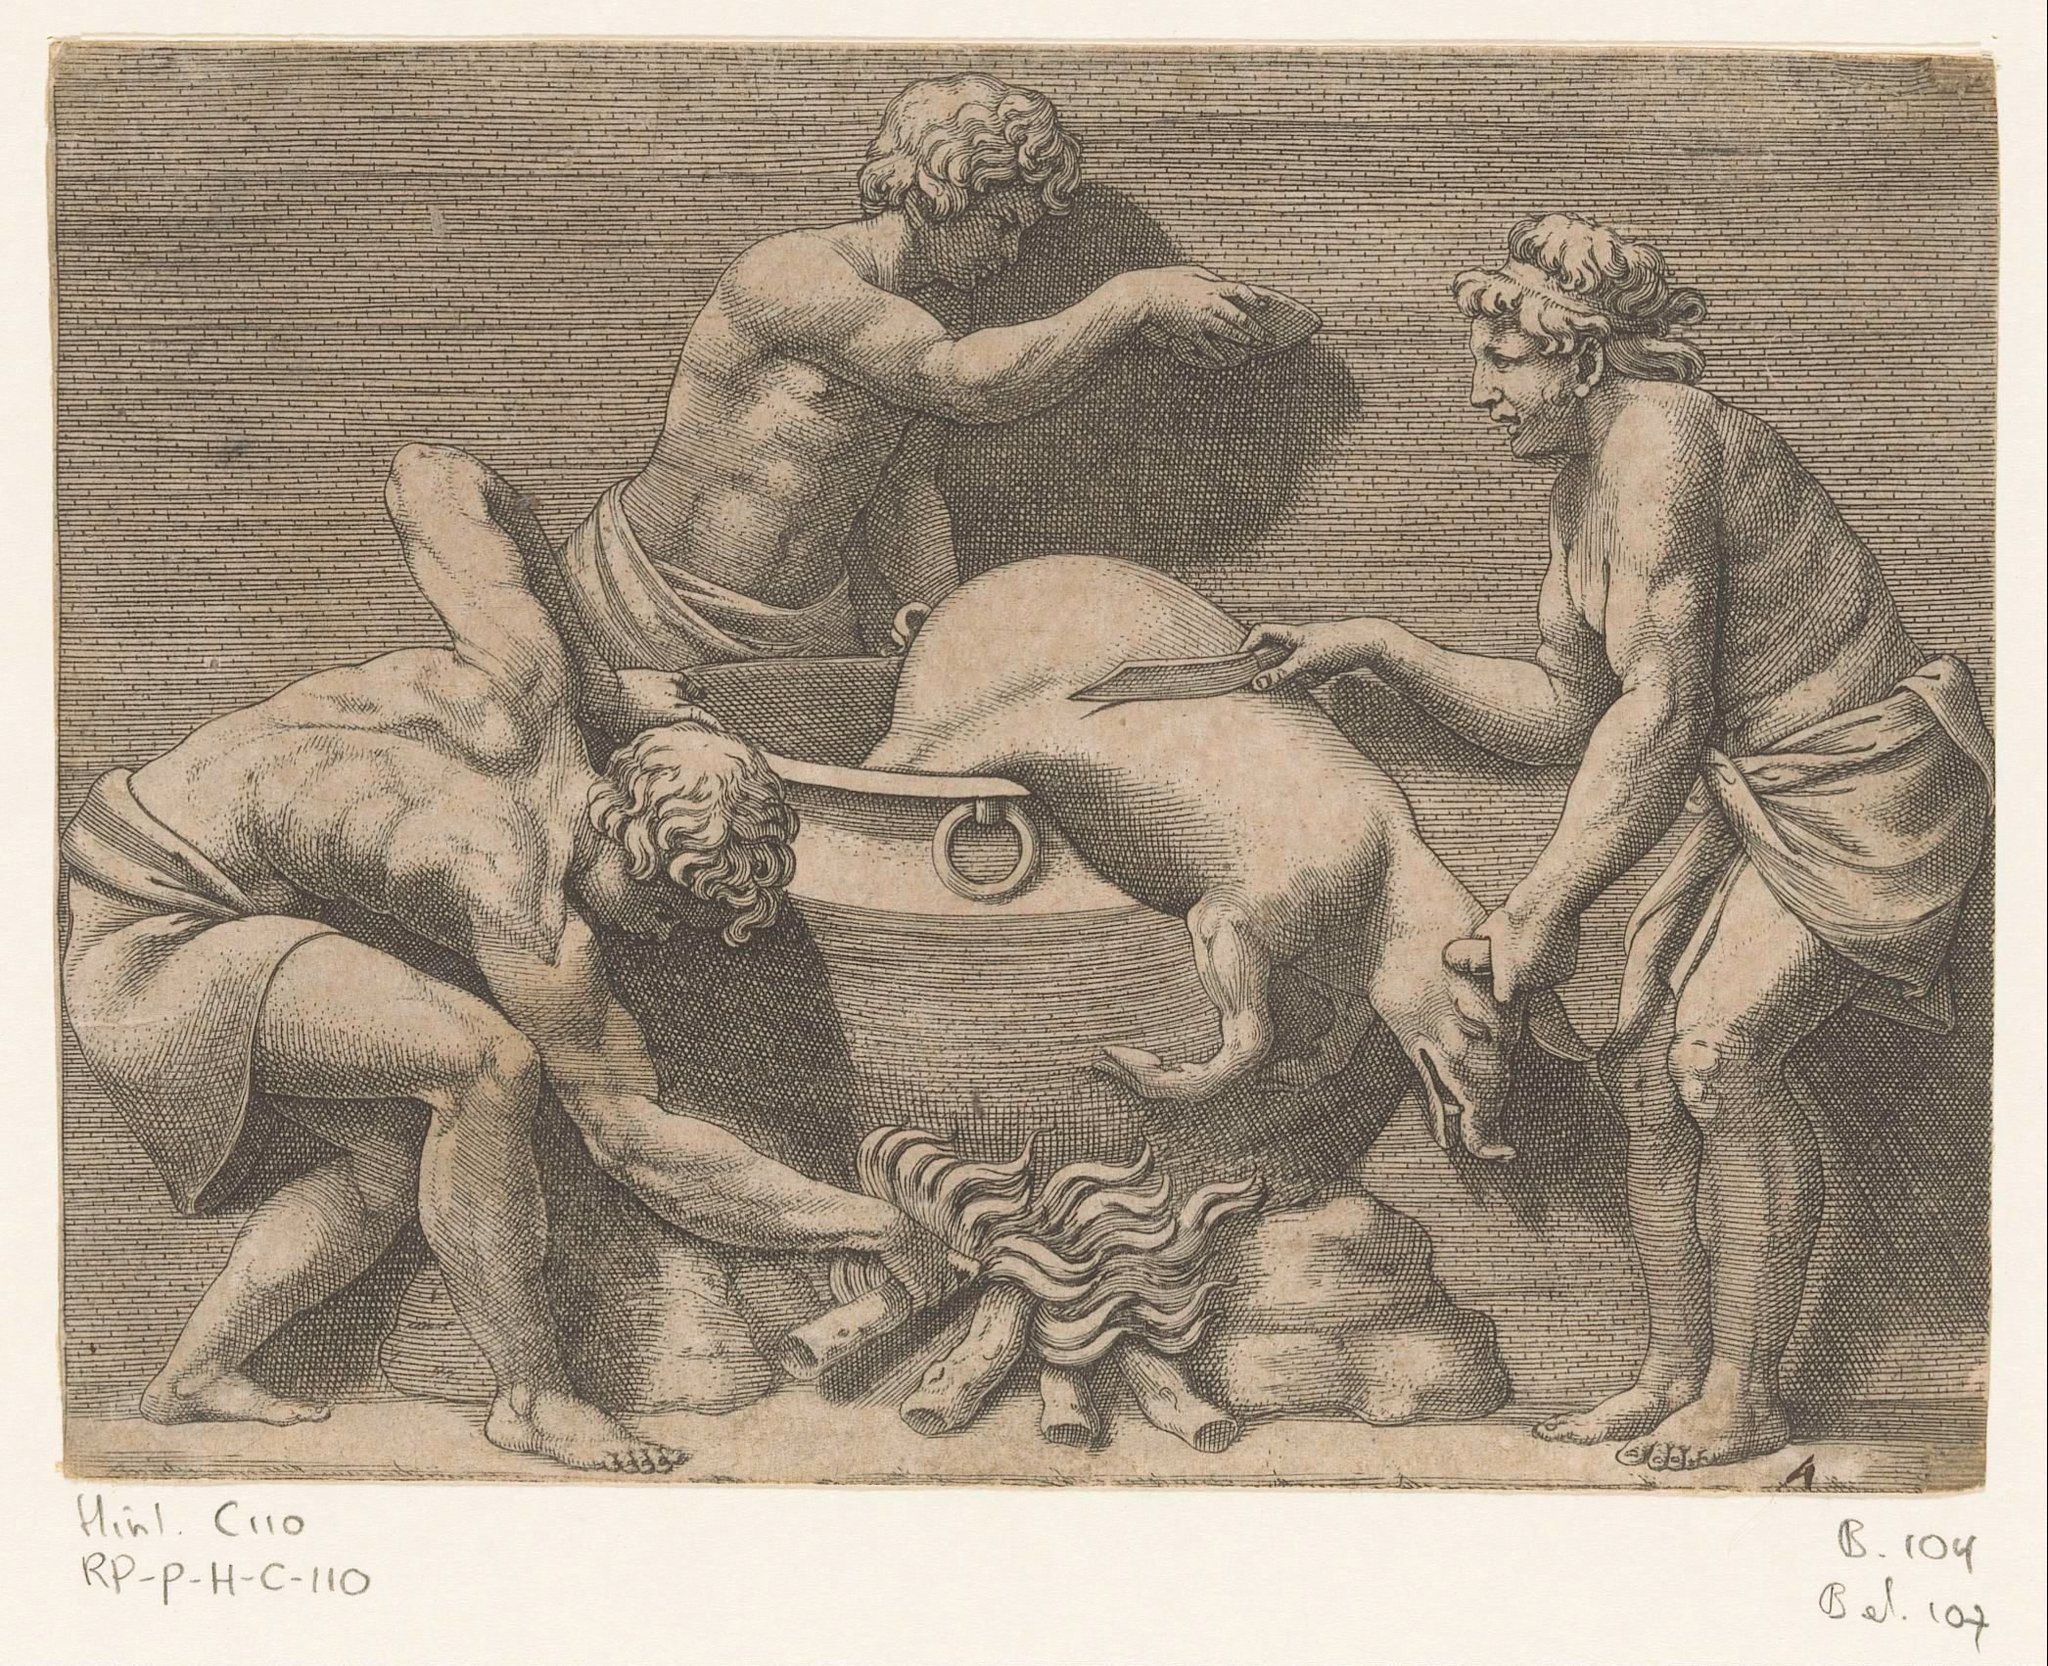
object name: print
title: Drie mannen offeren een varken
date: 1540-1585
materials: paper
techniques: engraving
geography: italy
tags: pig, animal sacrifice ~ roman religion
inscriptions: collector's mark: Lugt 11, collector's mark: Lugt 10, number: ‘4’, collector's mark: ‘Hinloopen’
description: Drie mannen staan om een pot heen. Onder de pot wordt een vuur gestookt en over de rand van de pot heen ligt een varken.